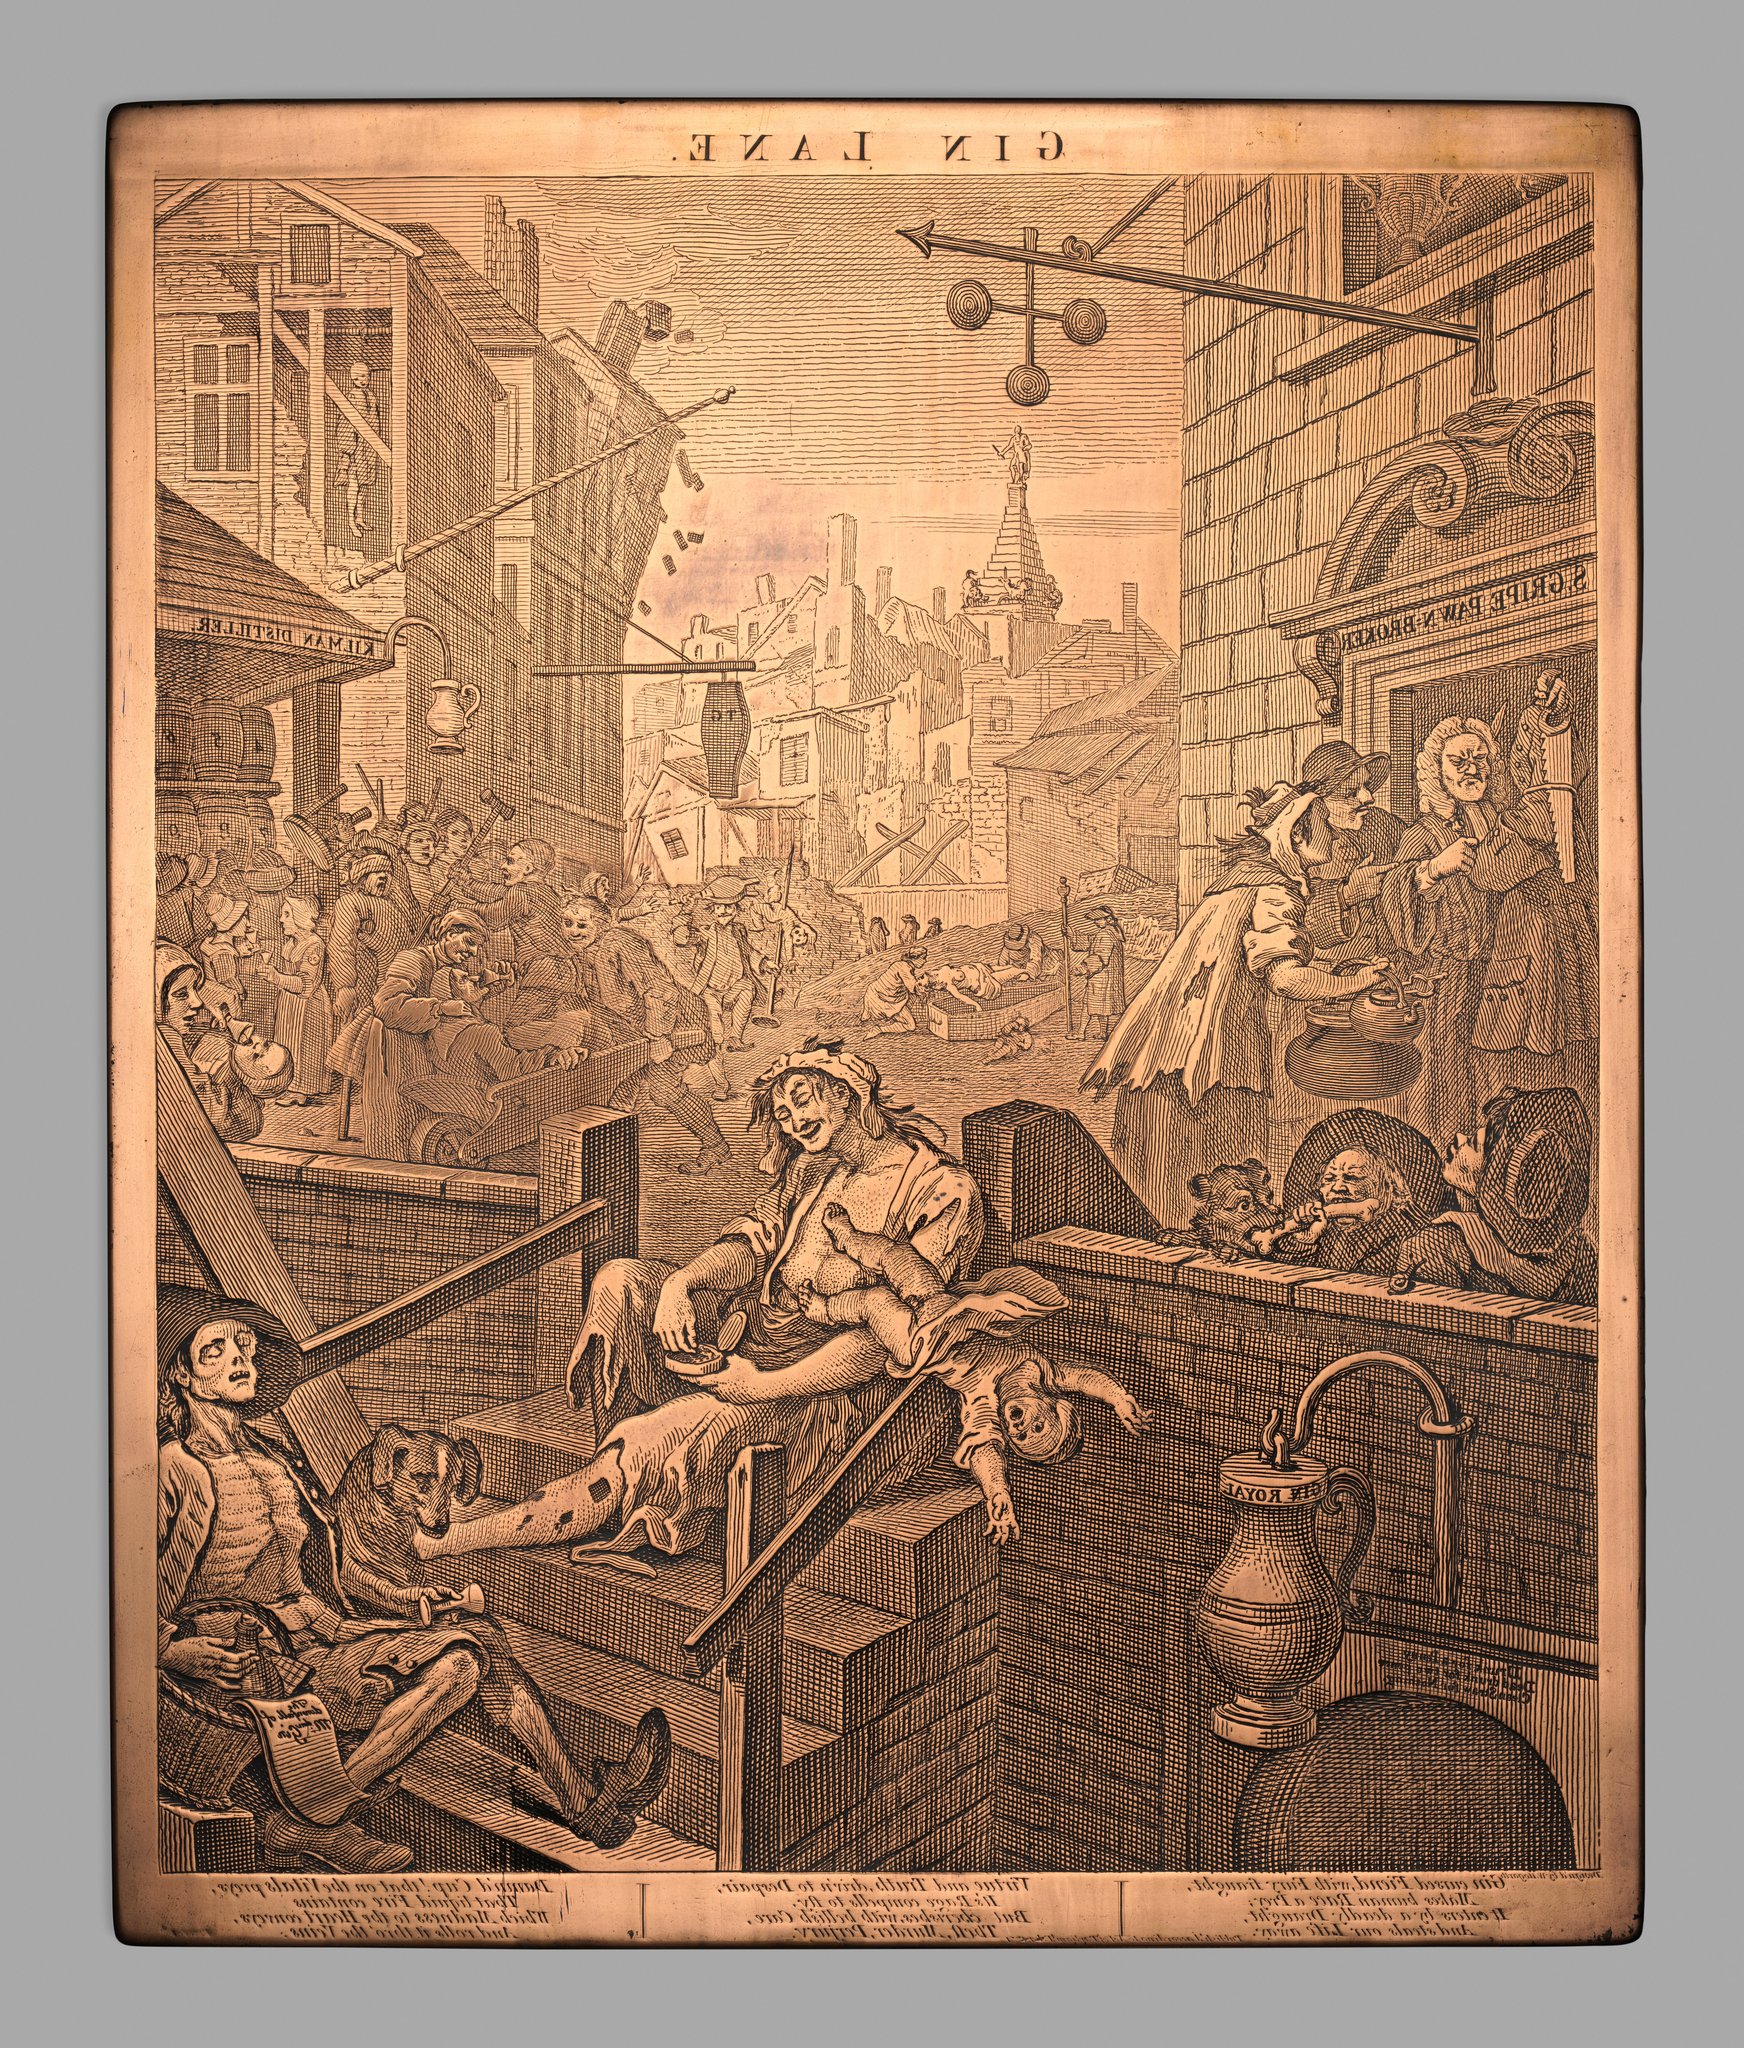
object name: plate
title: Gin Lane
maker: william hogarth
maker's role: artist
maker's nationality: british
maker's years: 1697-1764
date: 1751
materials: copper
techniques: engraving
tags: satire,men,women,dogs,drinking